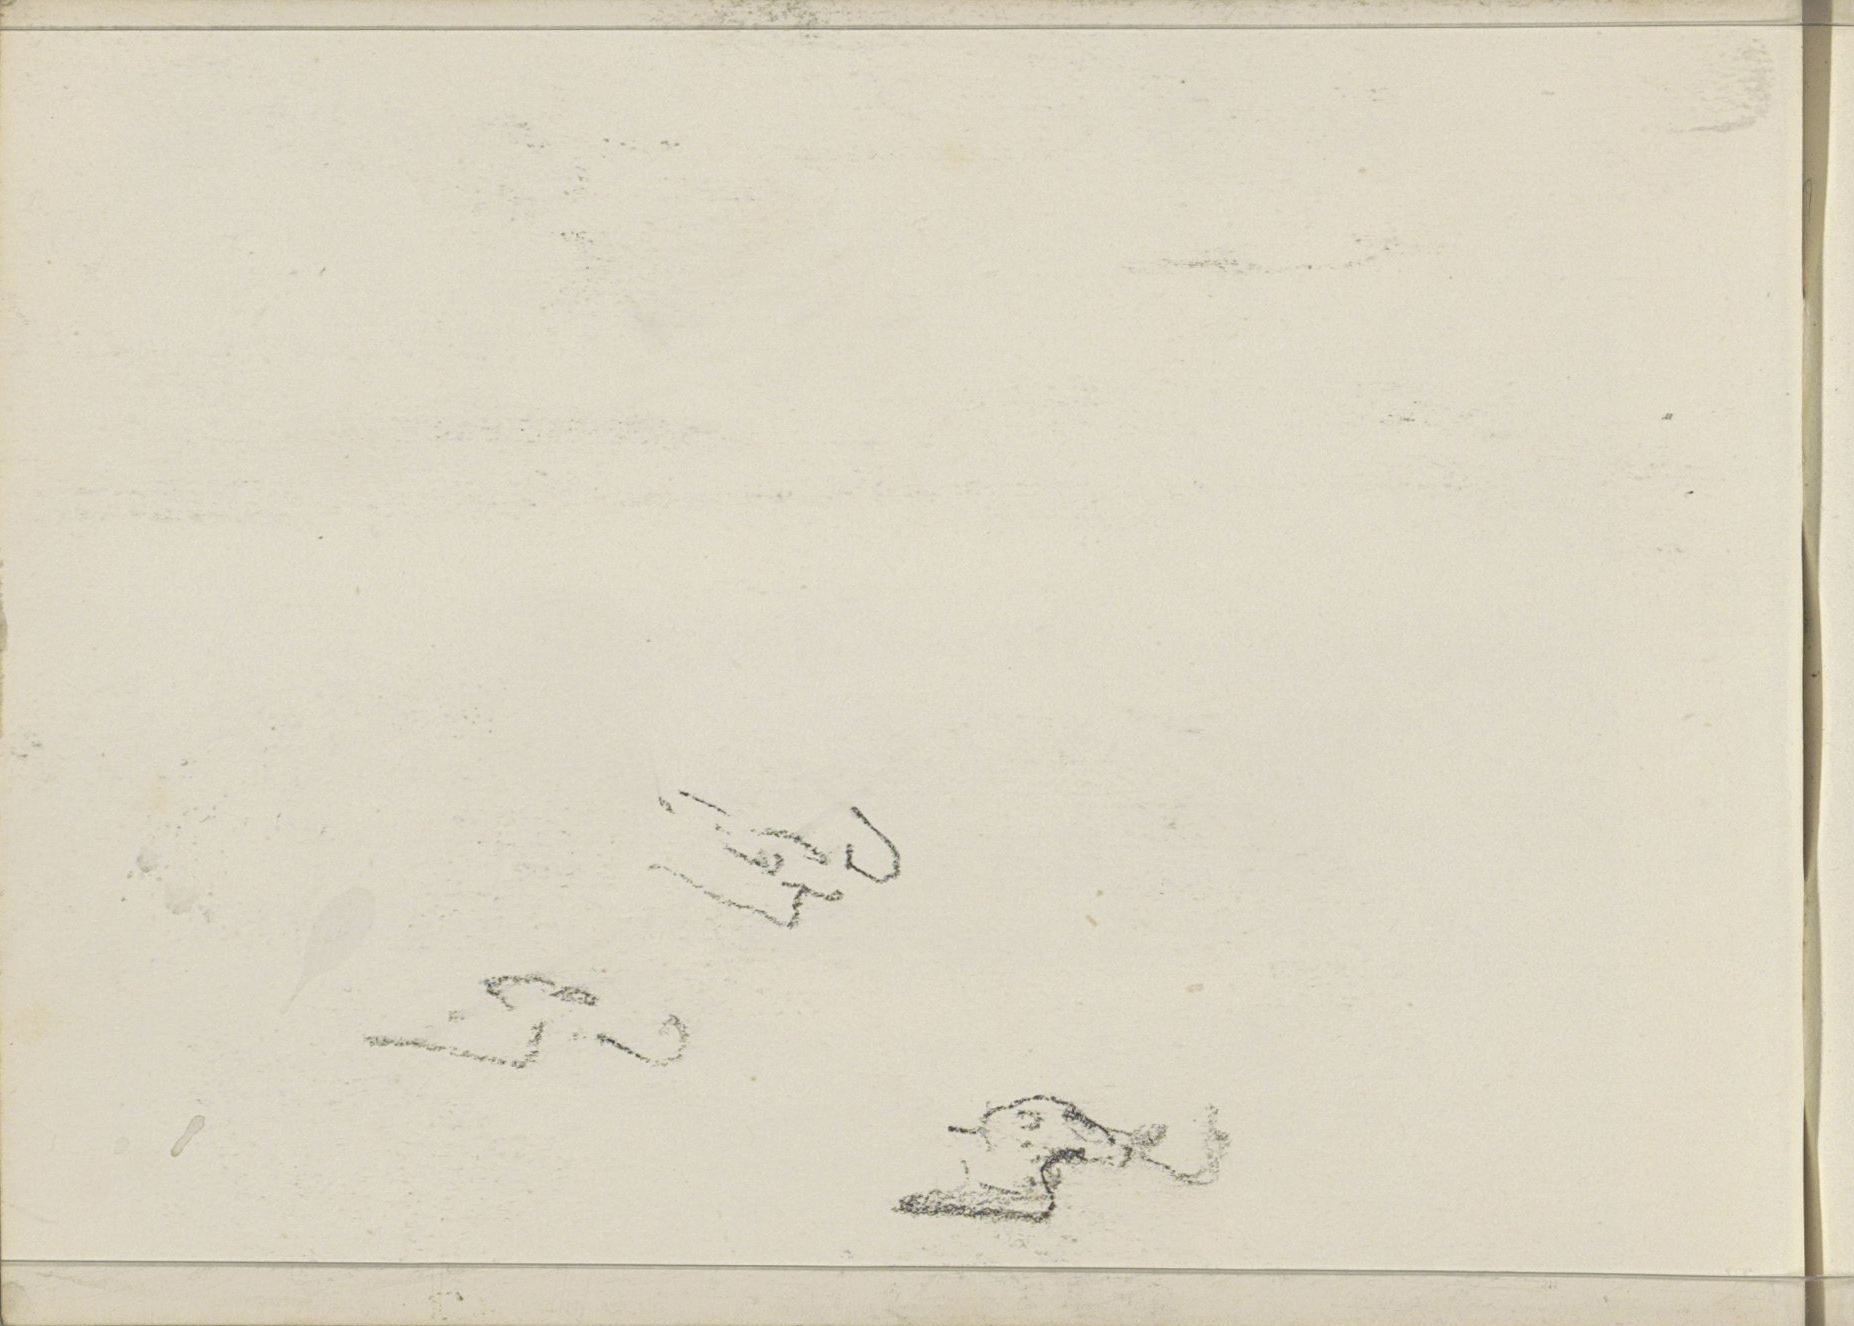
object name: sketchbook leaf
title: Vogels in vlucht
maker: johan antonie de jonge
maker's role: draughtsman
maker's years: 1864-1927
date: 1920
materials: chalk, paper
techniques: stumping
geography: south holland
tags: birds (+ animal(s) moving in the air)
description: Vogels in vlucht. Blad 20 verso uit een schetsboek met 21 bladen.